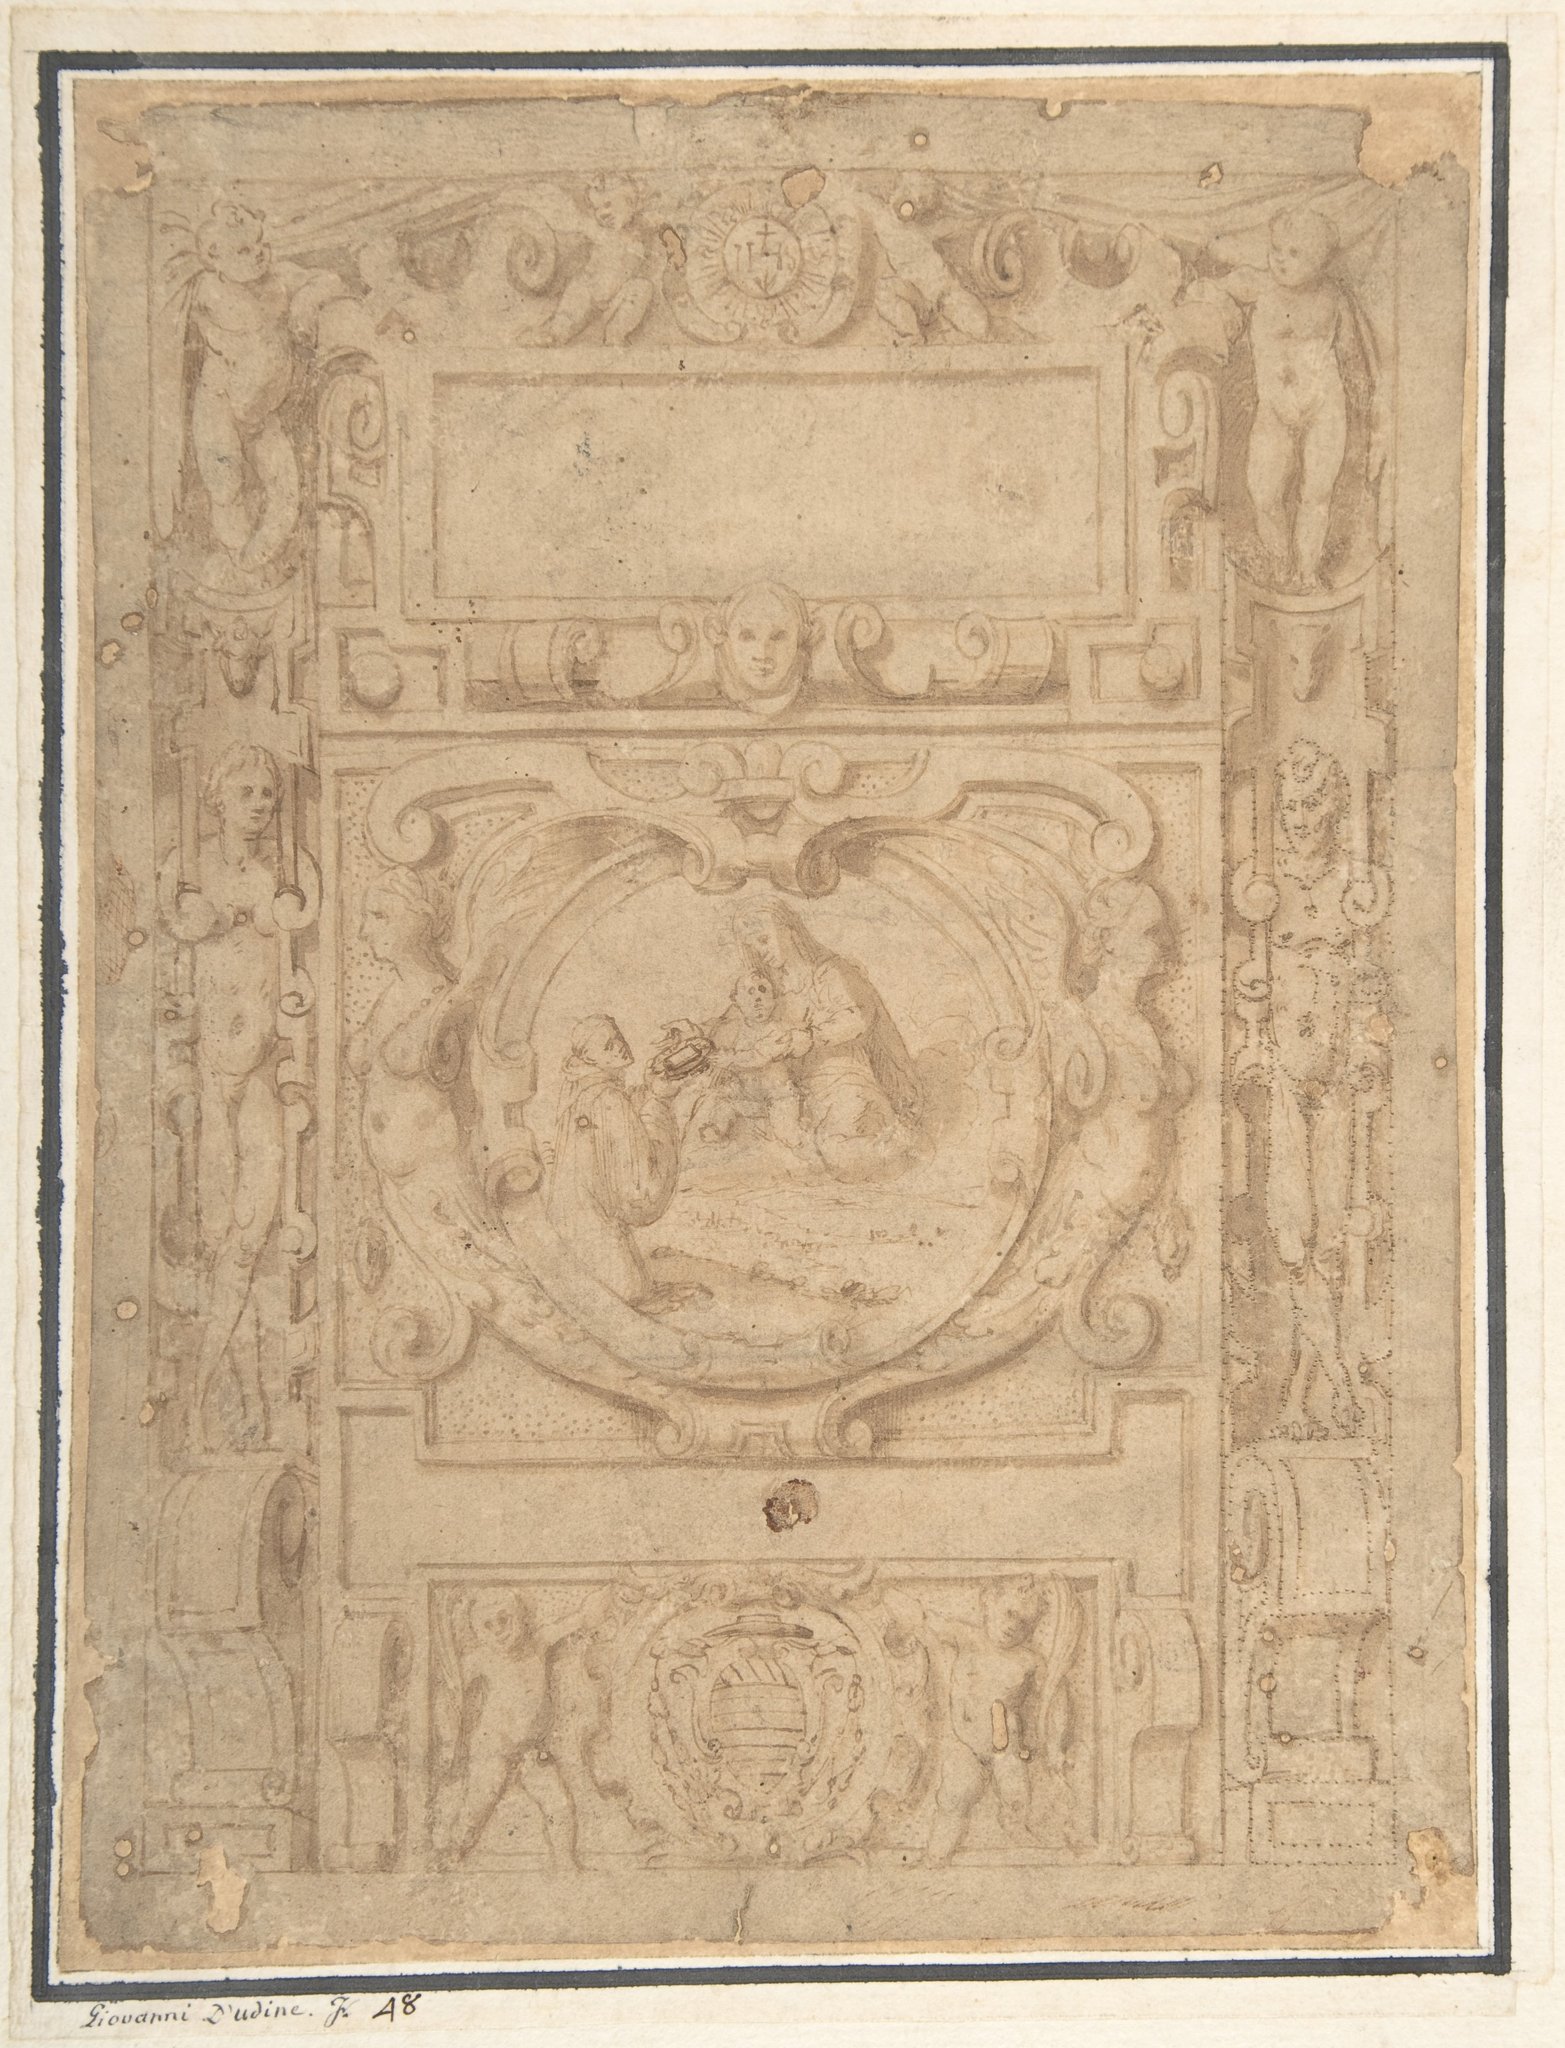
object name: drawing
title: Design for a Cartouche with the "IHS" Monogram of the Society of Jesus, Putti, Fantastick Creatures, at the Borders, a Central Scene of the Virgin and Child with a Monastic Figure, and the Family Arms of a Cardinal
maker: anonymous, italian, second half of the 16th century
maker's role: artist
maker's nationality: italian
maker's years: 1550-1600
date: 1550-1600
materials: ink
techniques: brush, pen, transfer, wash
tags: cartouches,putti,madonna and child,coat of arms